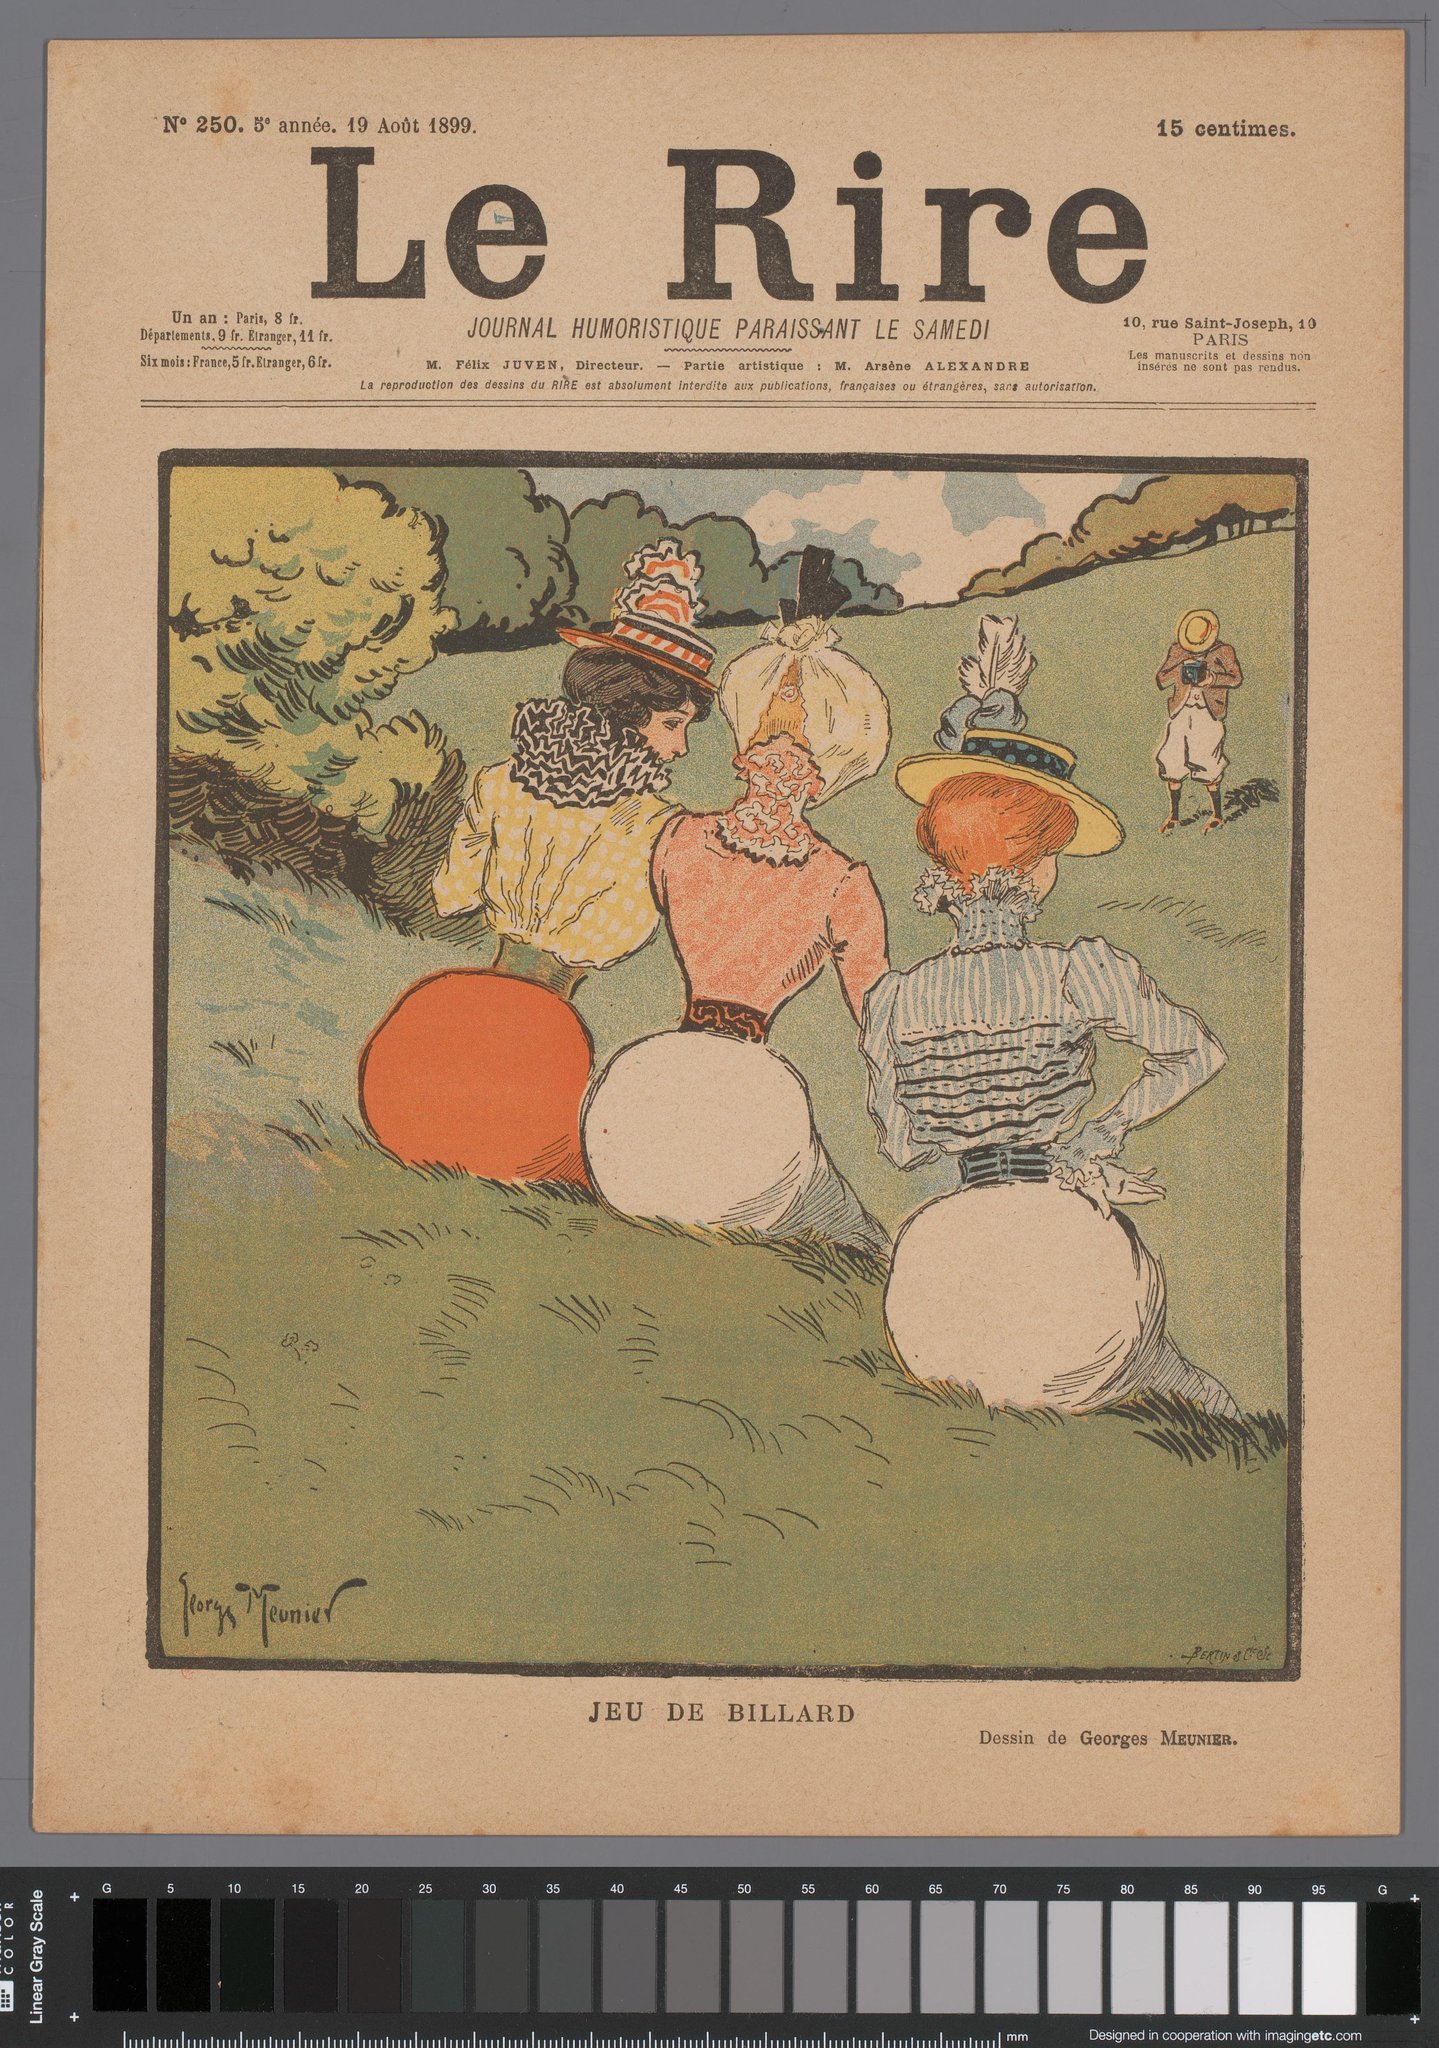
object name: print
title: Jeu de billard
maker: georges meunier (tekenaar)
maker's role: draughtsman, painter, print maker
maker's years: 1869-1942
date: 1899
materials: paper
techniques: lithograph, letterpress printing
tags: billiards, adolescent, young woman, maiden, taking photographs - cc - out of doors, buttocks, 'partes posteriores' - aa - female human figure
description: Een fotograaf kiekt drie dames op het gras met derrières als een biljartspel. Exemplaar van de humoristische krant 'Le Rire' van 19 augustus 1899.